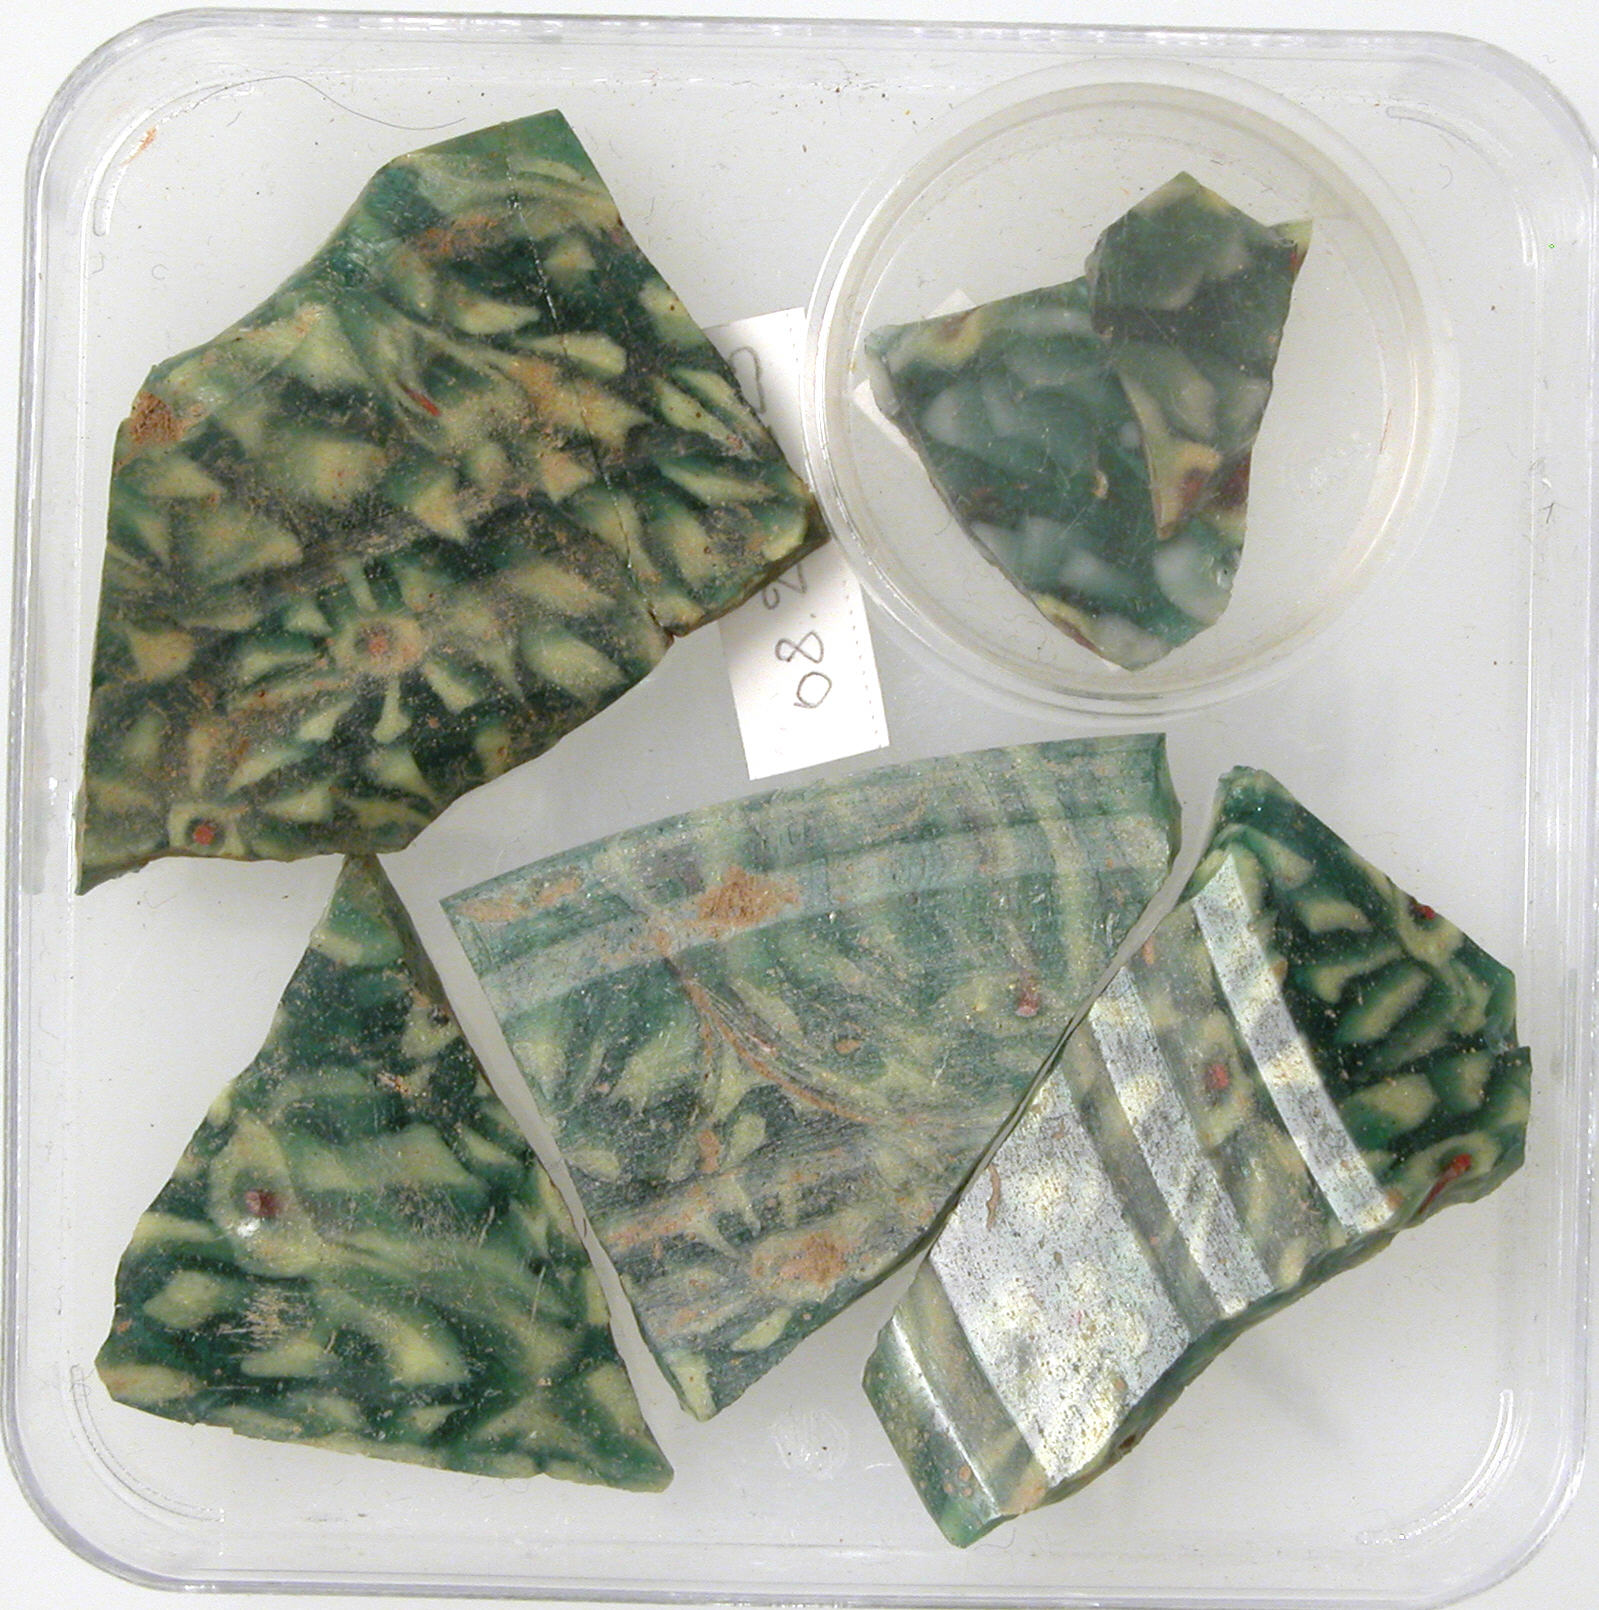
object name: fragment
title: Glass Fragments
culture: coptic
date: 301-433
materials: glass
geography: egypt